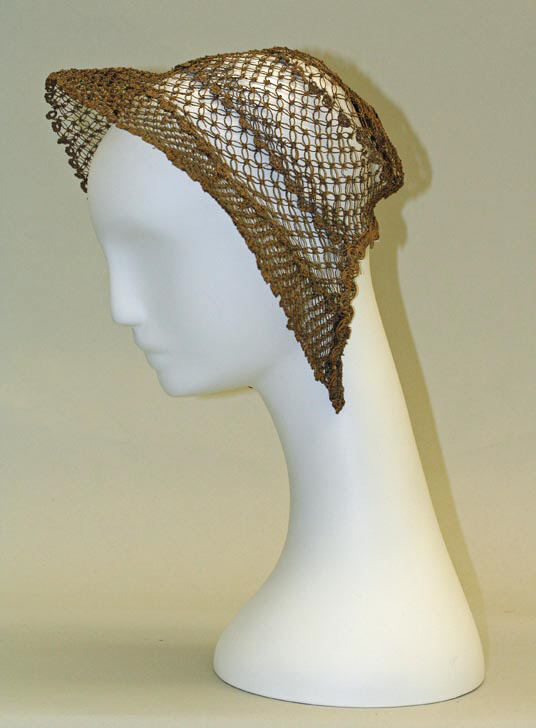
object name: bonnet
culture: american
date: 1853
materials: silk